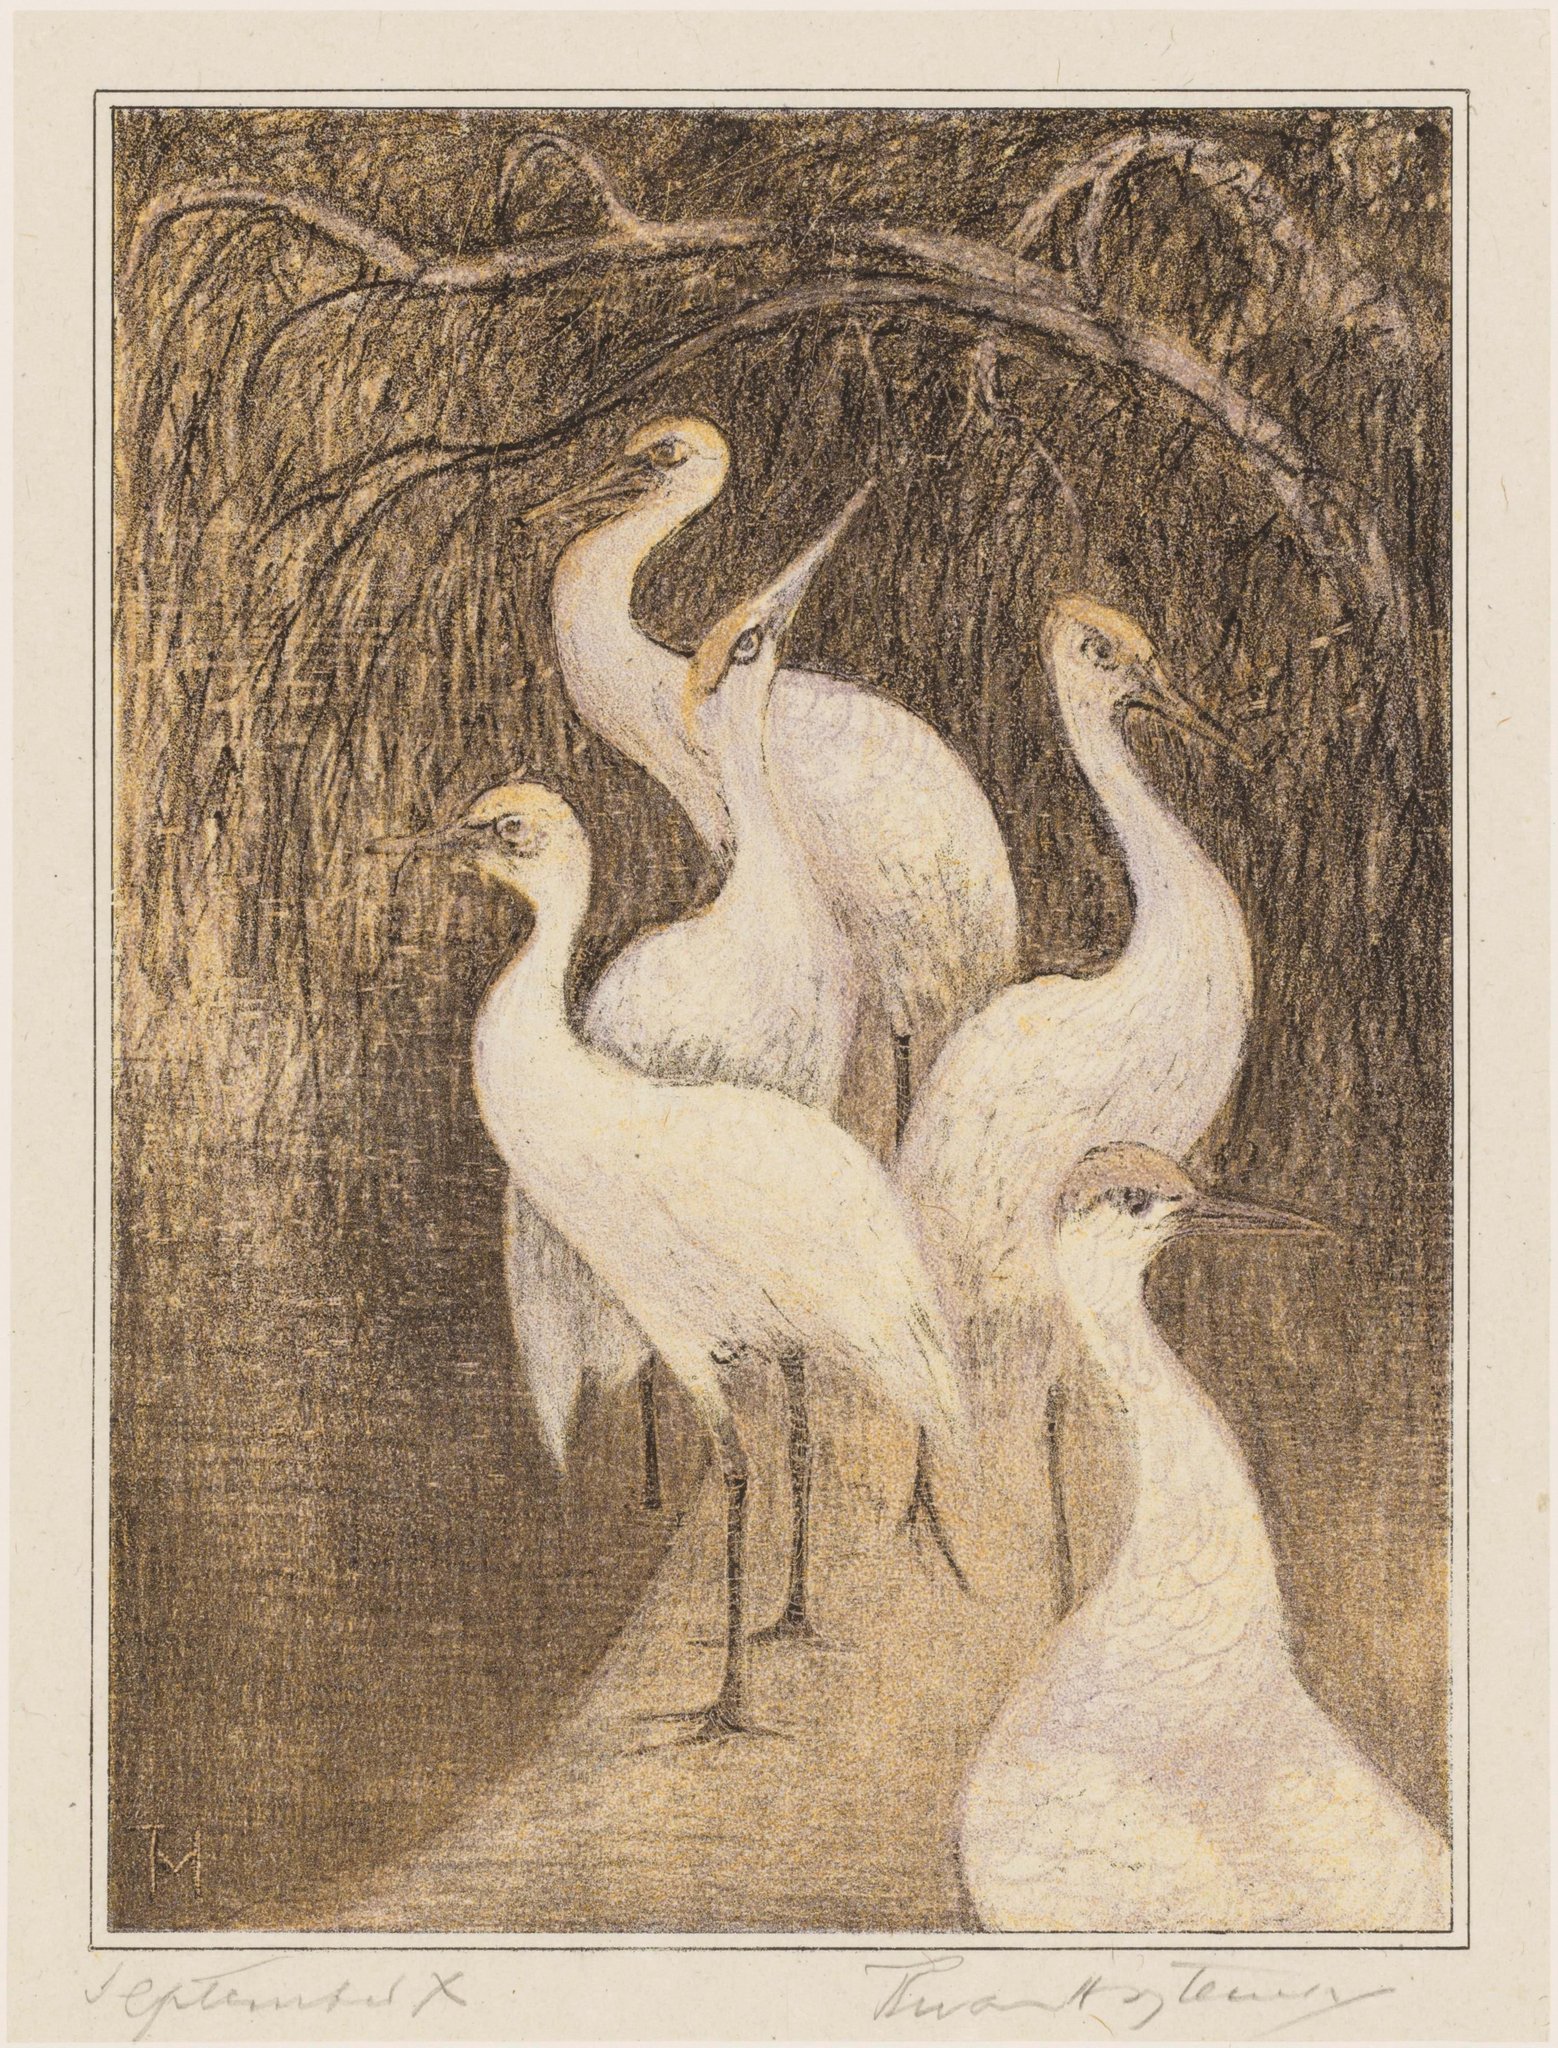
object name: print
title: Kraanvogels aan de waterkant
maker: theo van hoytema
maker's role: draughtsman, painter, print maker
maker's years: 1863-1917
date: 1878-1910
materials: paper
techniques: lithograph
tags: shore-birds and wading-birds: crane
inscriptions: collector's mark: Lugt 2233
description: Prent is een proefdruk voor kalenderblad september 1910.